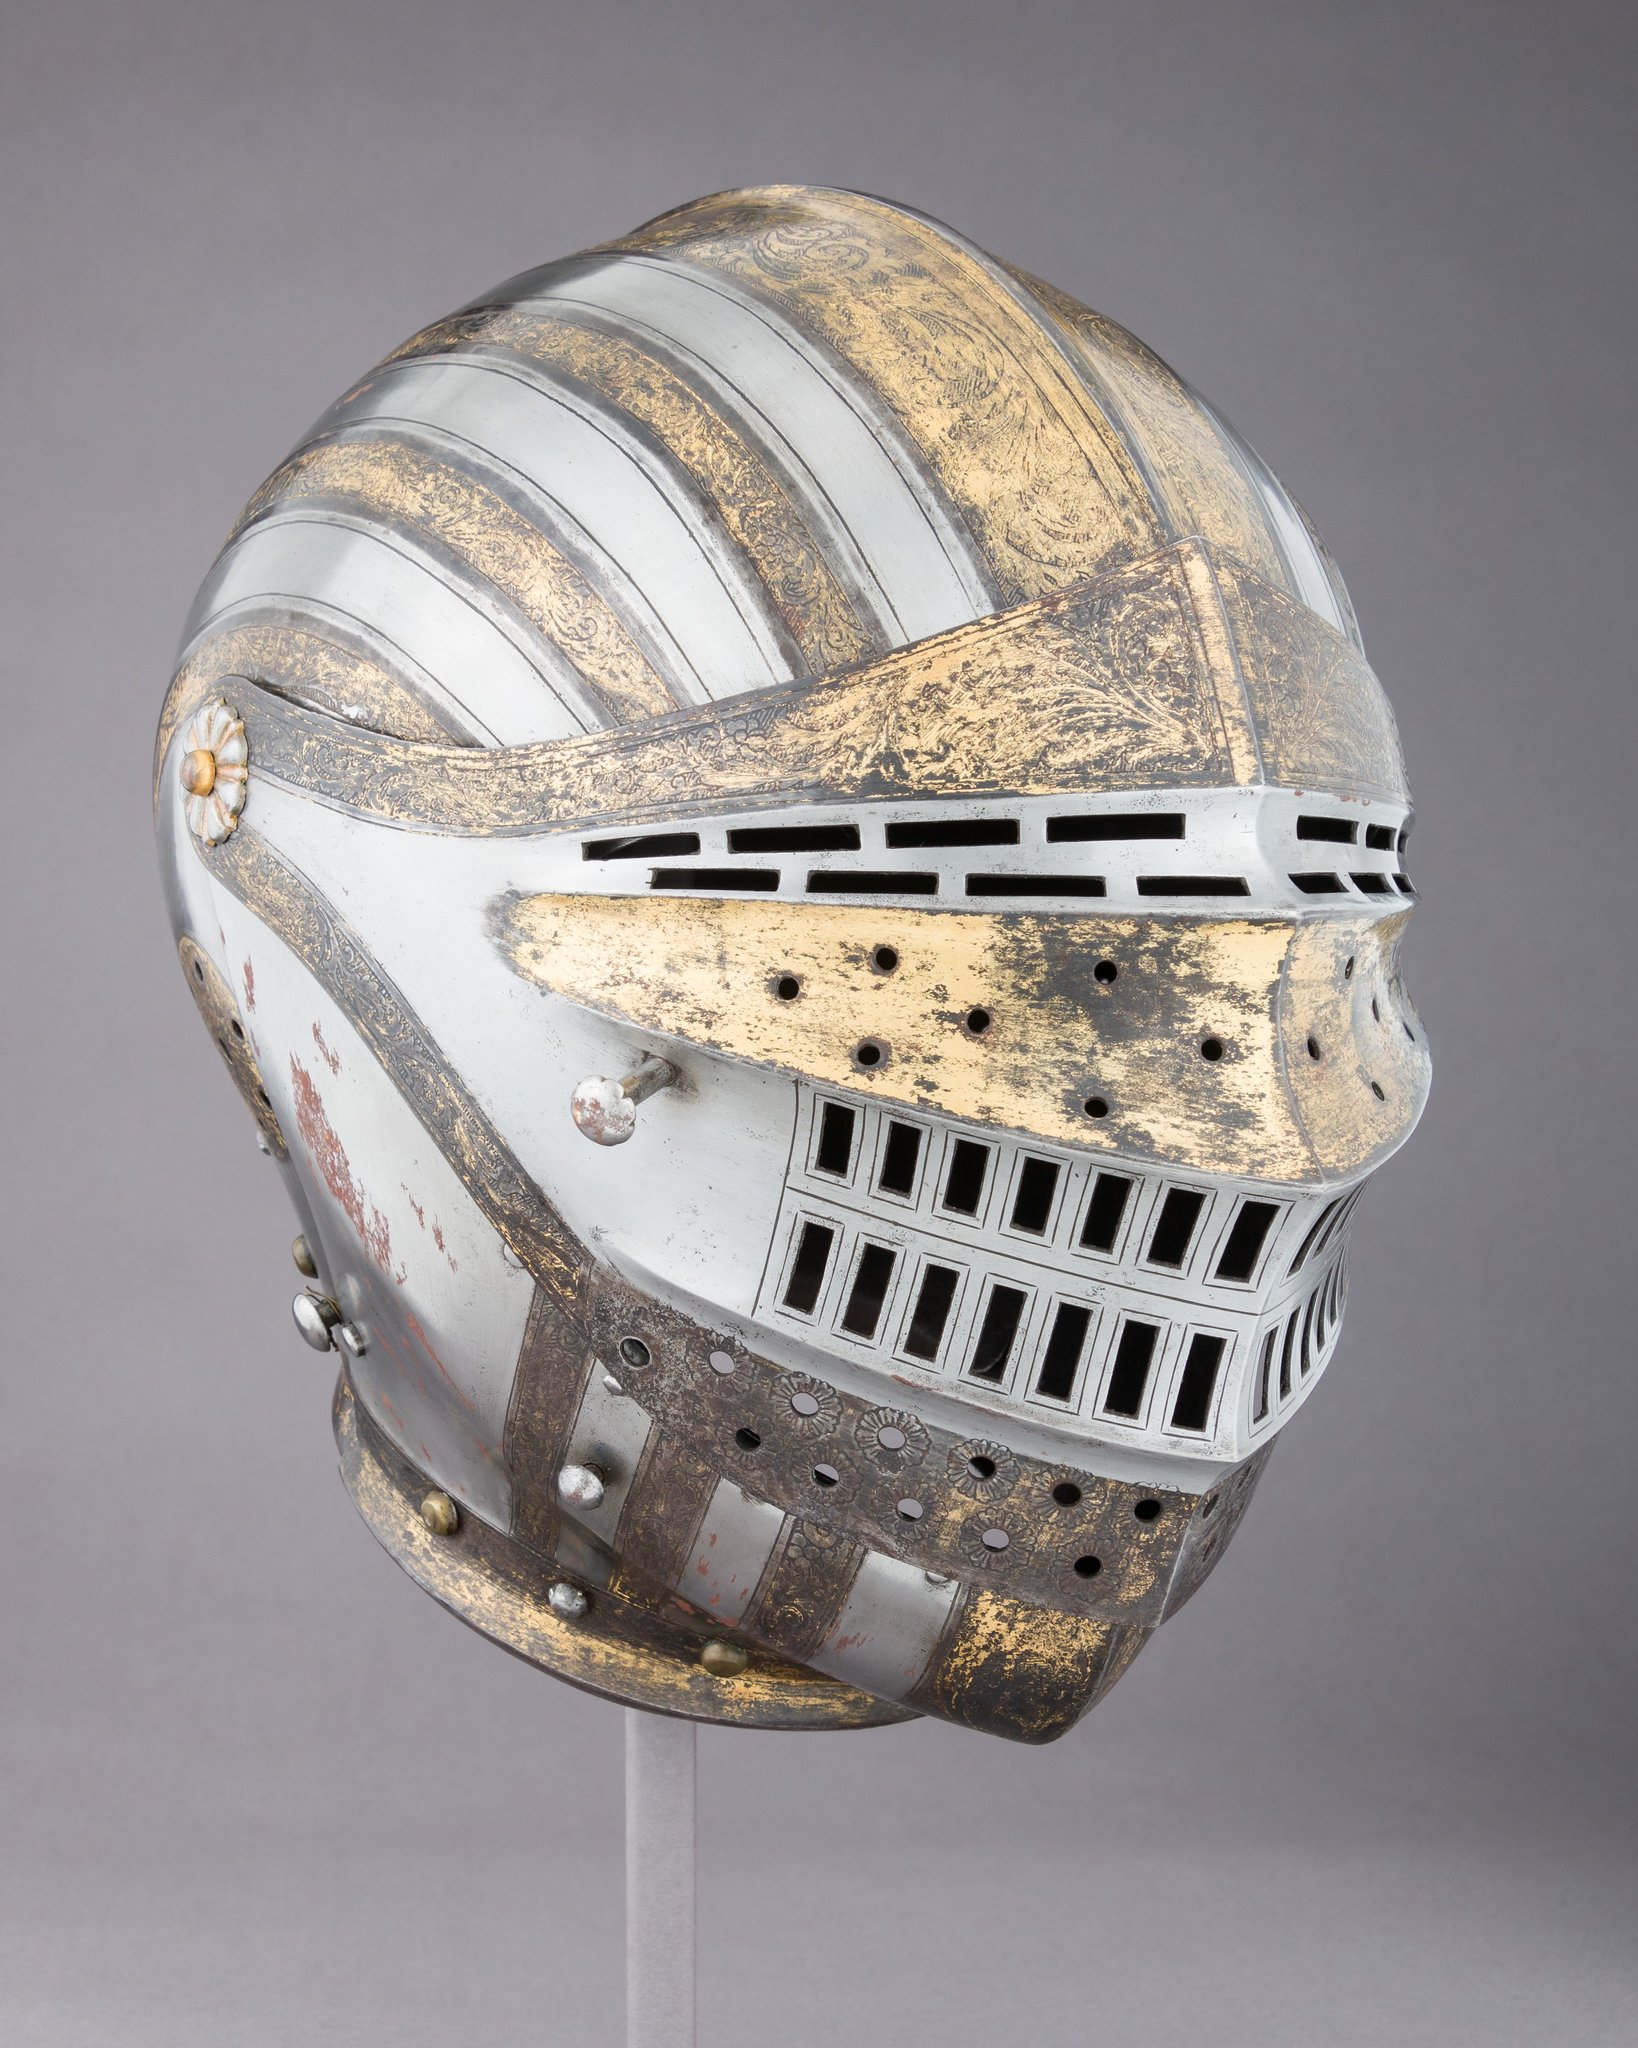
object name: close helmet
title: Close-Helmet in the style of the 16th century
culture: french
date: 1875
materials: copper alloy, gold, steel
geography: france